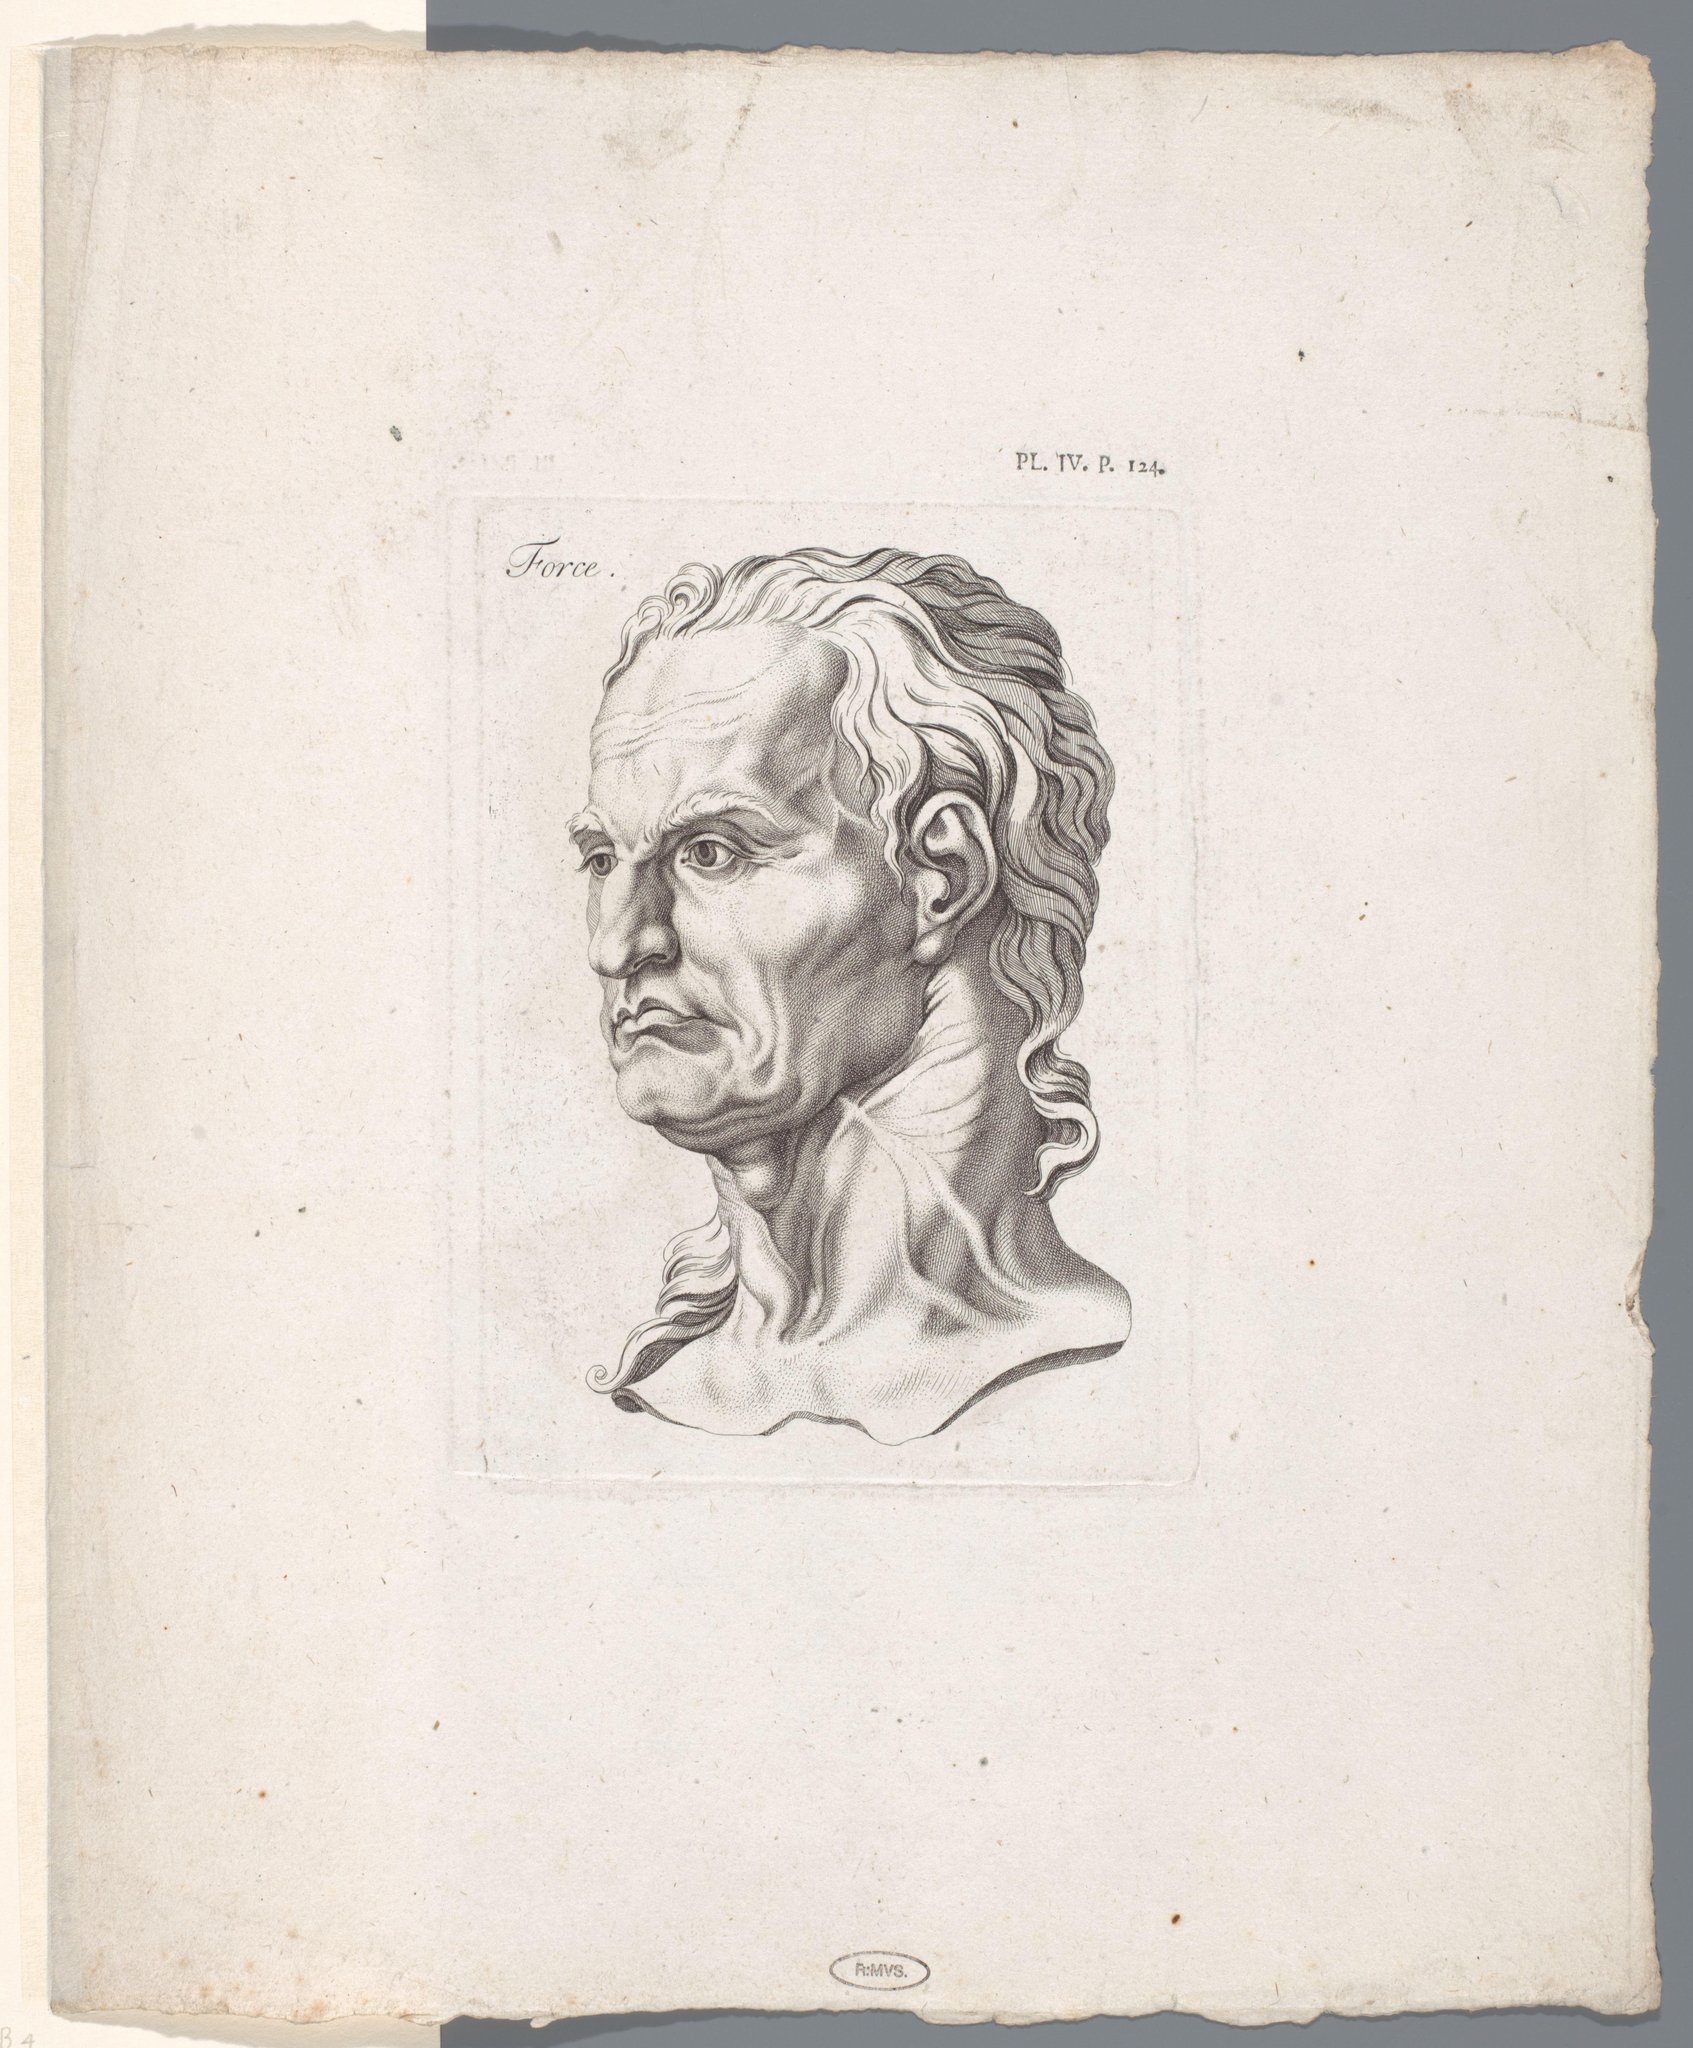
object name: print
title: Force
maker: Anonymous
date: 1700-1799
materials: paper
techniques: engraving, etching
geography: france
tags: head (human), strength, power; 'fortezza', 'fortezza d'animo e di corpo', 'fortezza del corpo congiunta con la generosità dell'animo', 'fortezza & valore del corpo congiunto con la prudenza & virtù del animo', 'forza' (ripa)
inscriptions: collector's mark: Lugt 2228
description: Buste van een man. Genummerd rechtsboven buiten plaatrand: PL. IV. P. 124.